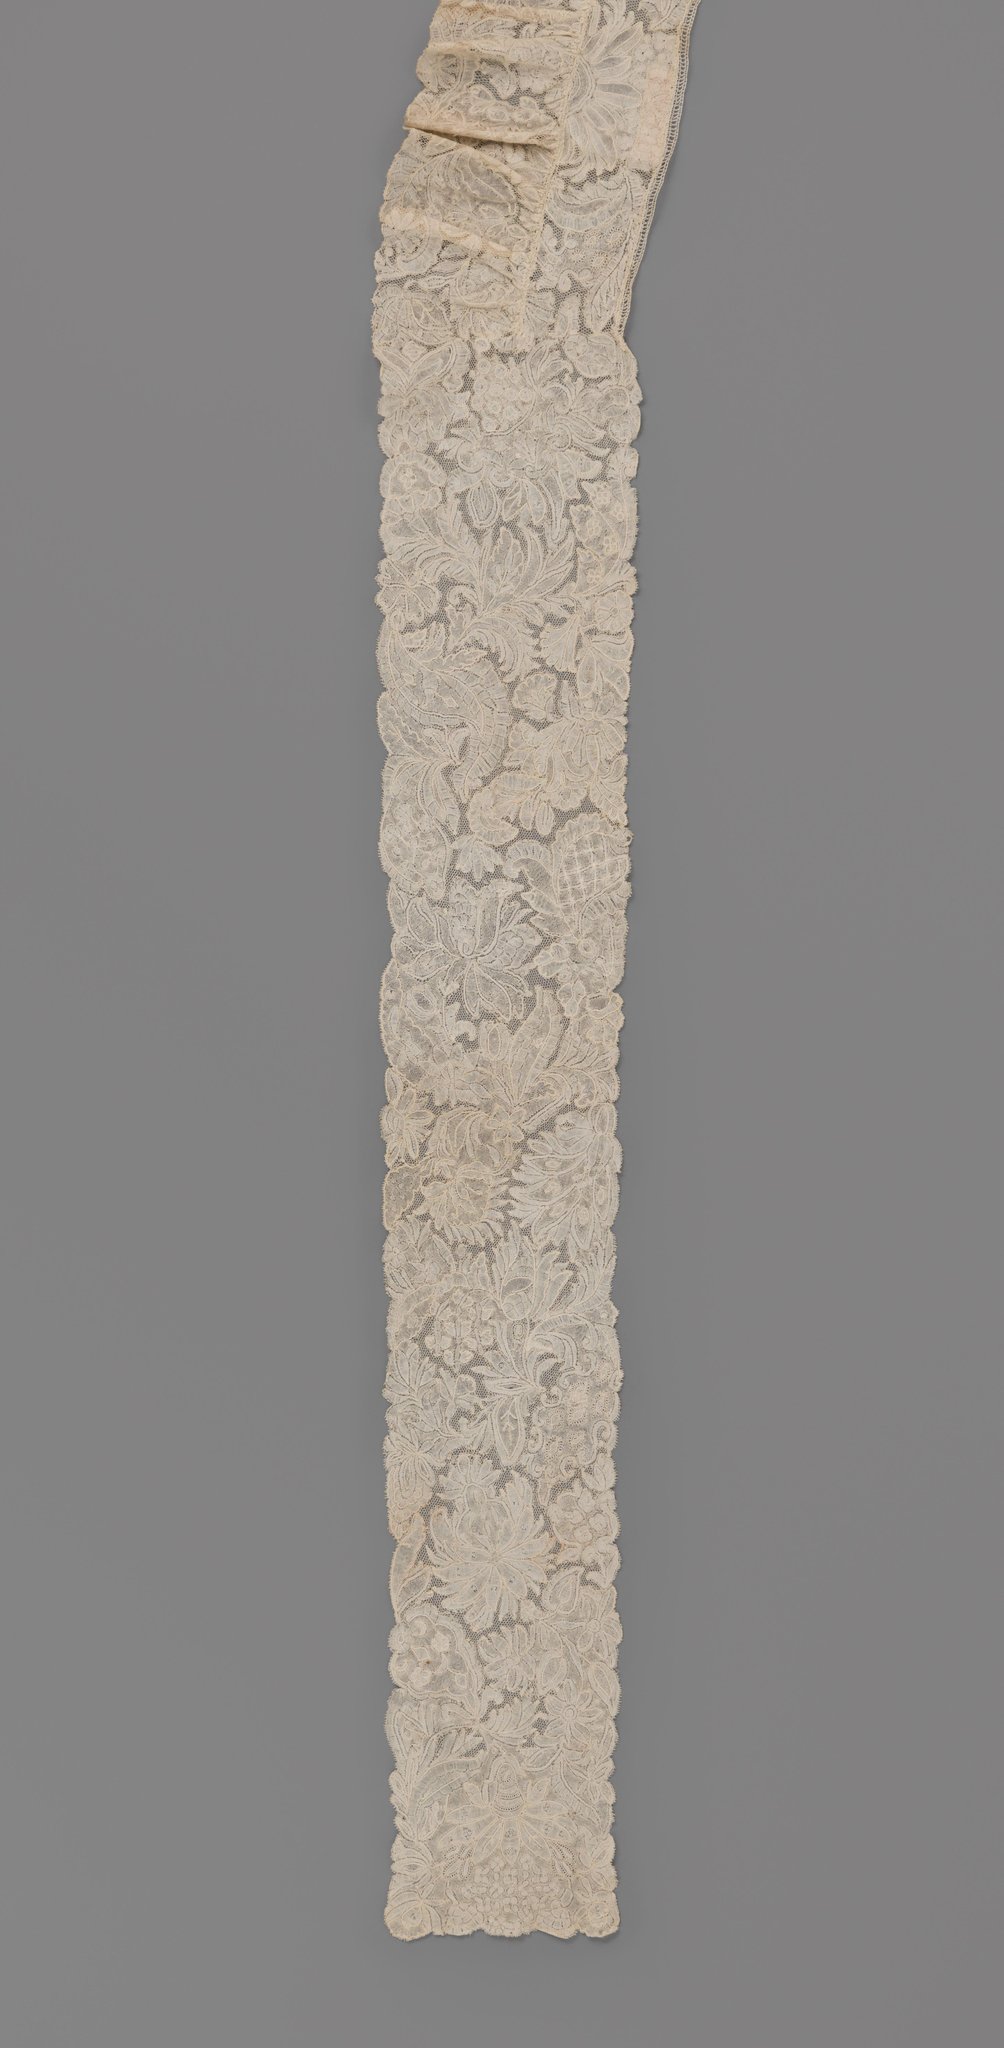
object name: womenswear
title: Mutsenslippen van Brusselse kloskant met voorhoofdstrook uit twee stukken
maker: Anonymous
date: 1735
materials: linen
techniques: lace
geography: brabant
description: Mutsenslippen van Brusselse kloskant met voorhoofdstrook uit twee stukken. De voorhoofdstrook is gerimpeld aangezet. Het geheel is onregelmatig geschulpt en voorzien van een picotrand. De slippen hebben rechte uiteinden. Verschillende contouren in het patroon van bloemen en gebladerte zijn verhoogd.